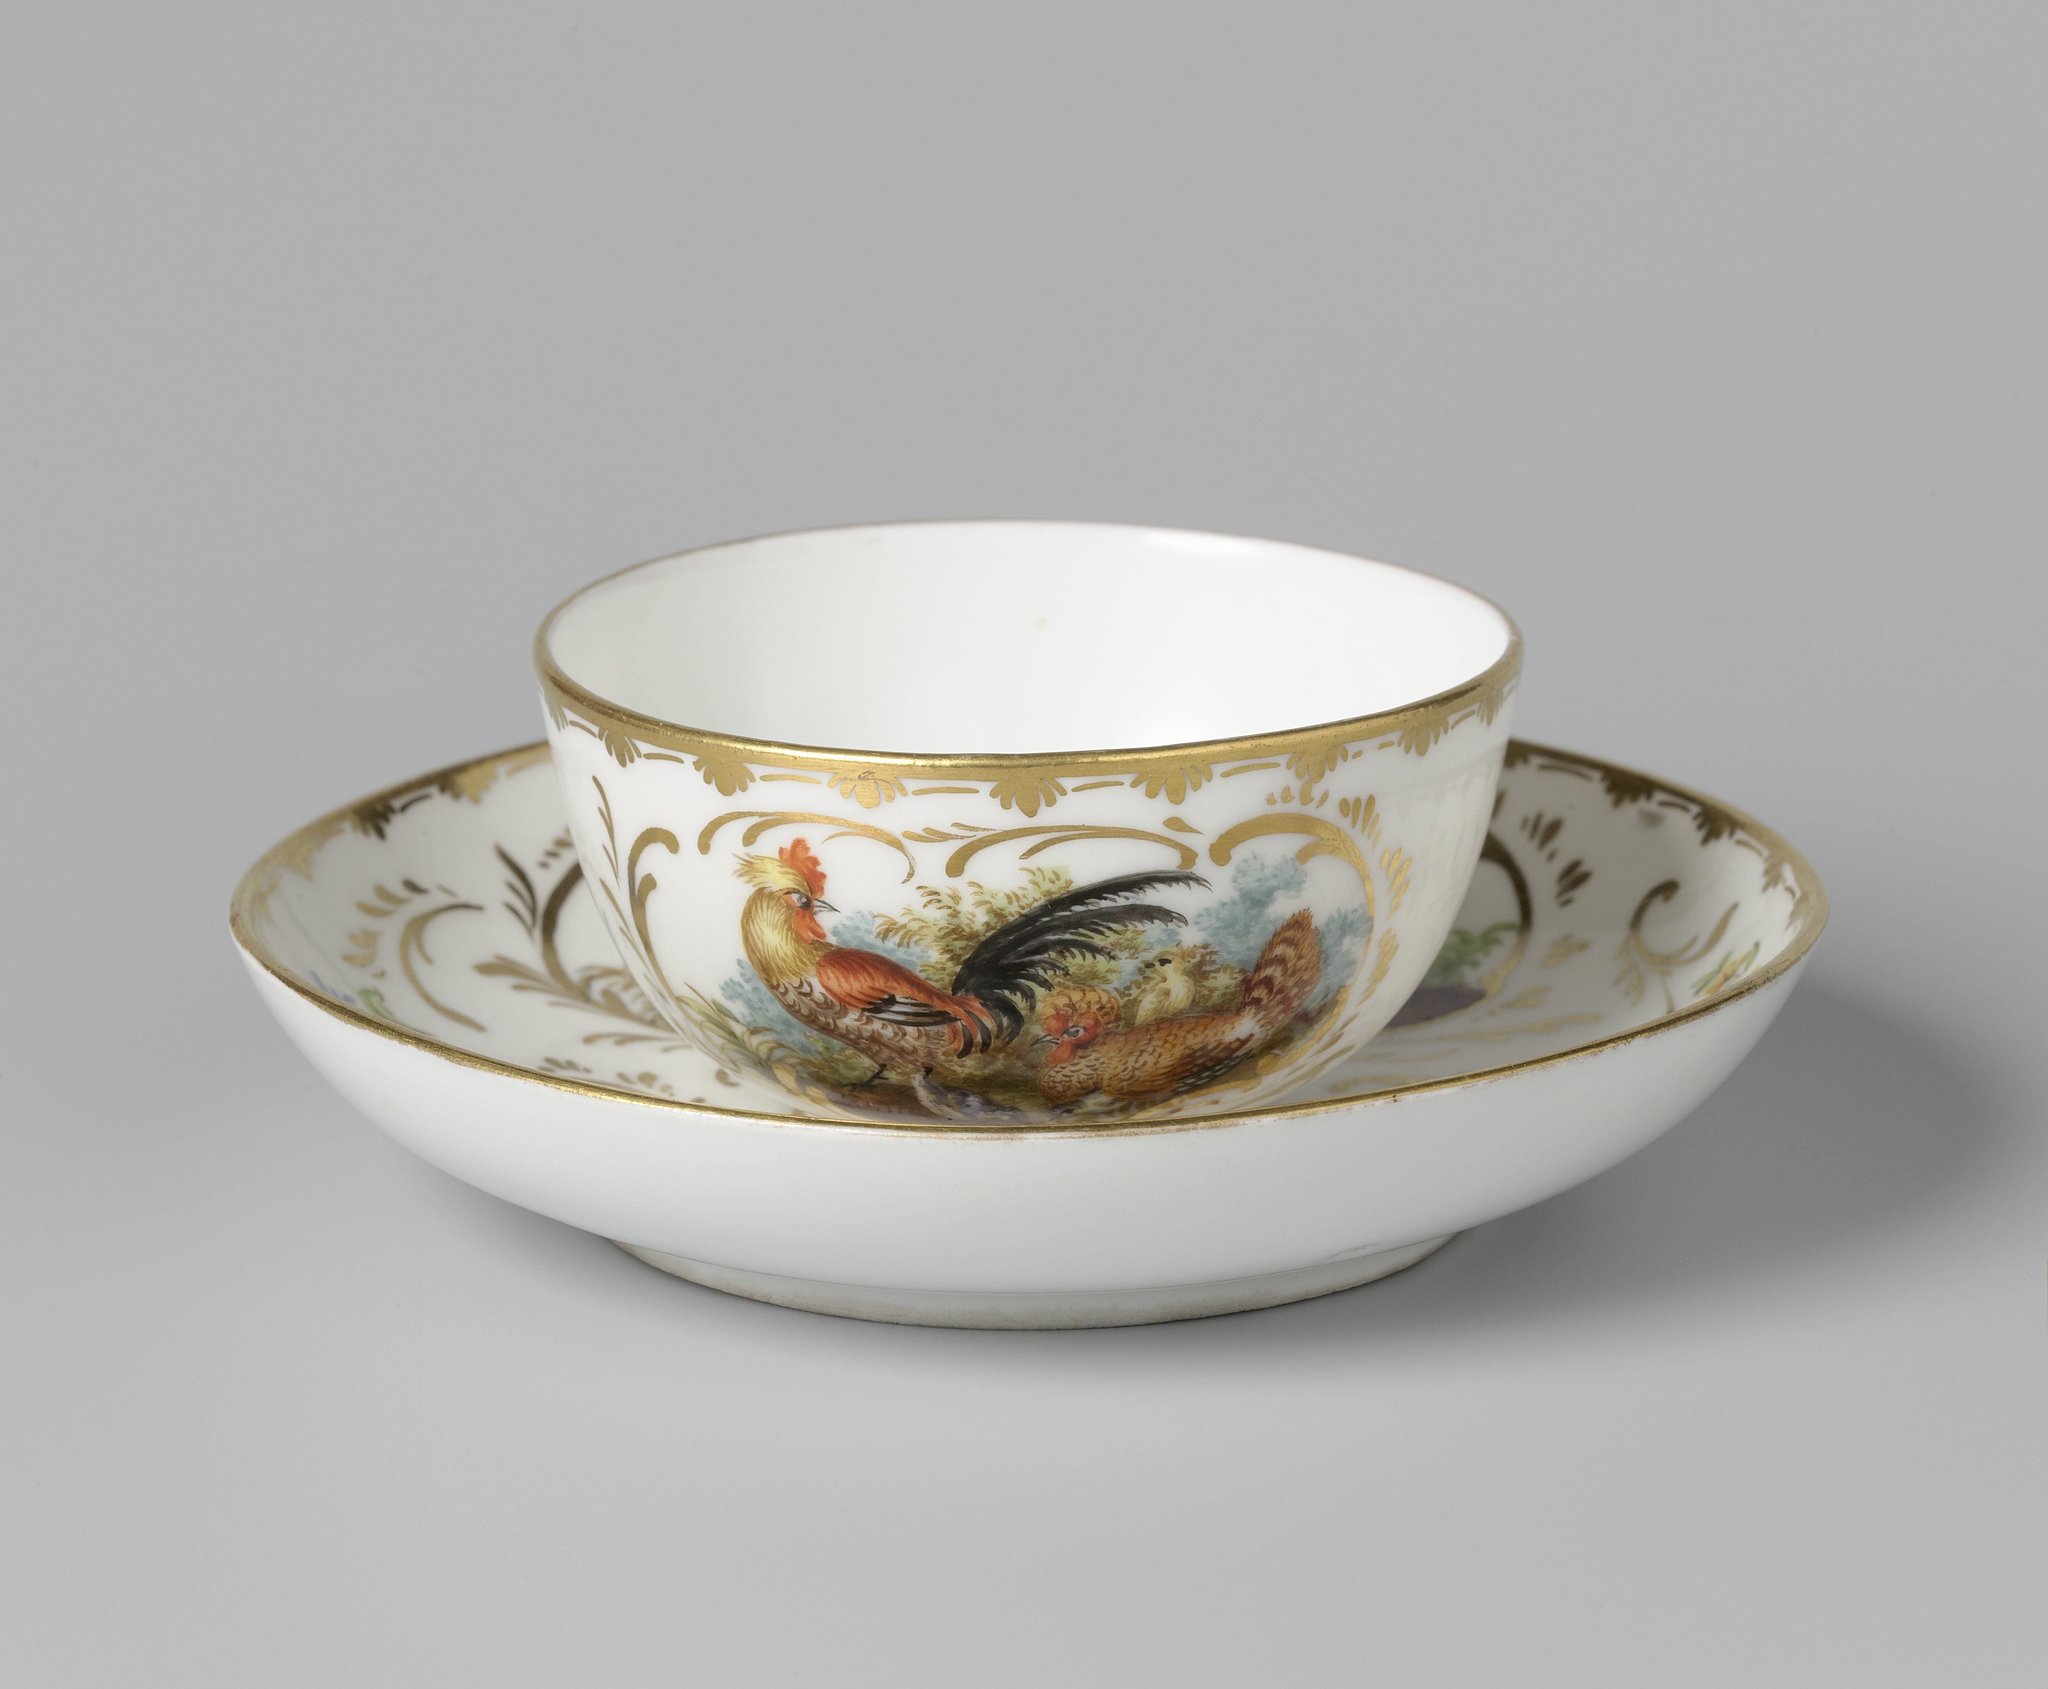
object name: cup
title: Kop, beschilderd met vogels in een landschap binnen cartouches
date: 1778-1782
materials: porcelain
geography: loosdrecht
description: Tea cup and saucer. Porcelain. Loosdrecht, 1778 - 1782. Factory of Joannes de Mol. Given by the Belport Familien Stiftung, 1983.